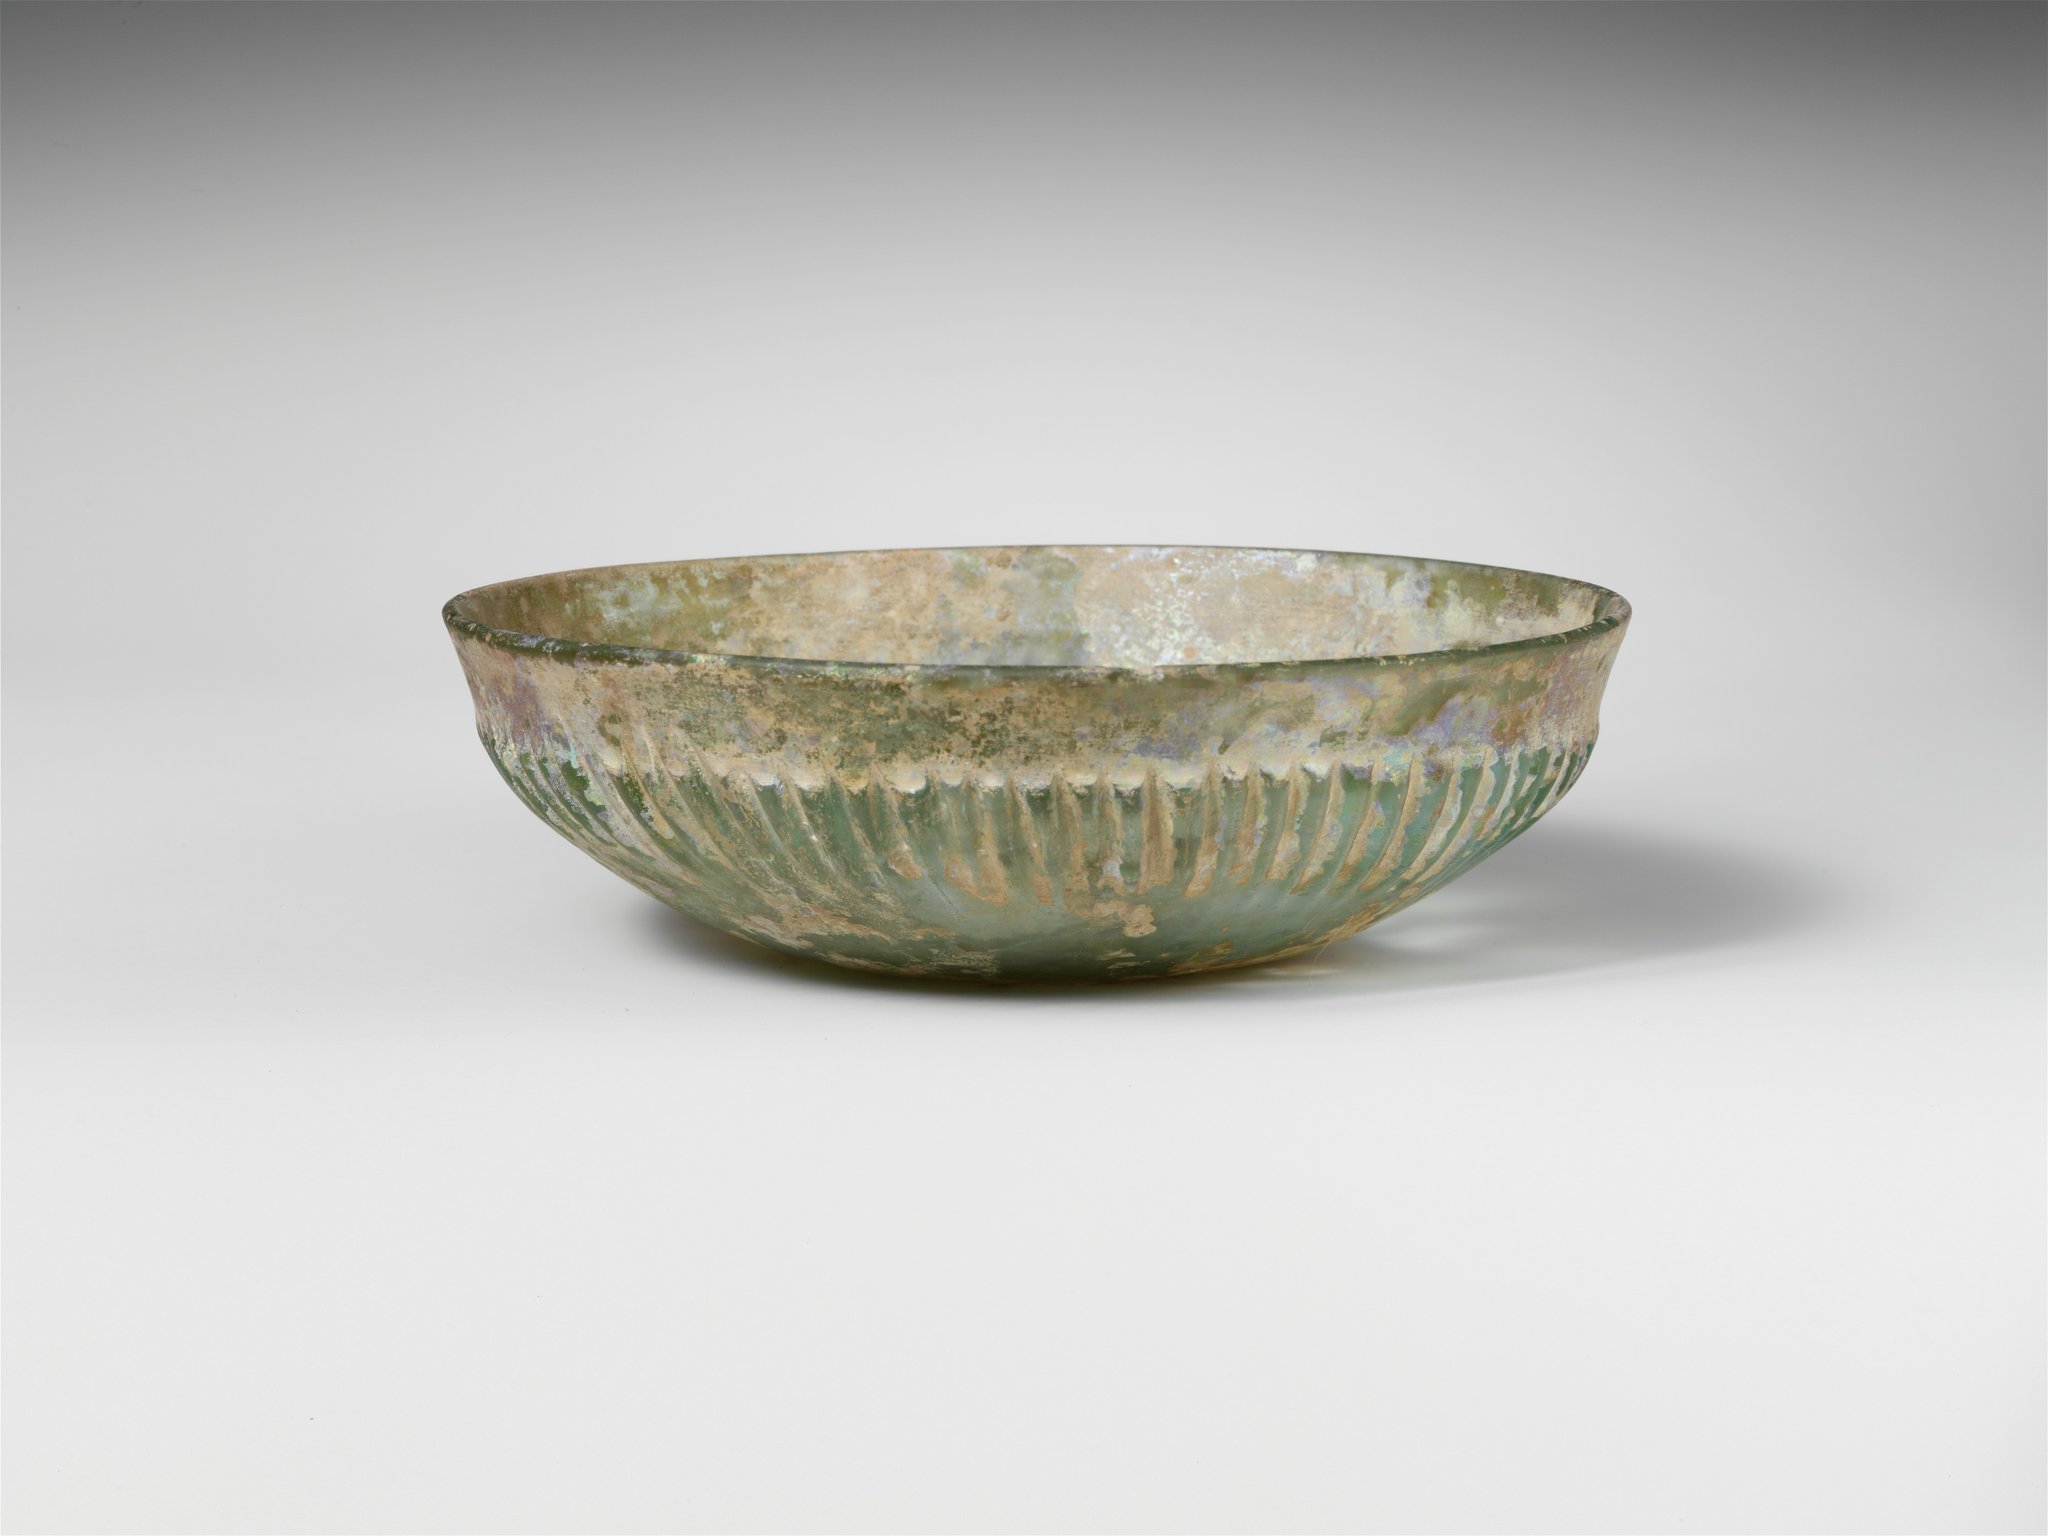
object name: bowl, ribbed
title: Glass ribbed bowl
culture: roman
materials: glass